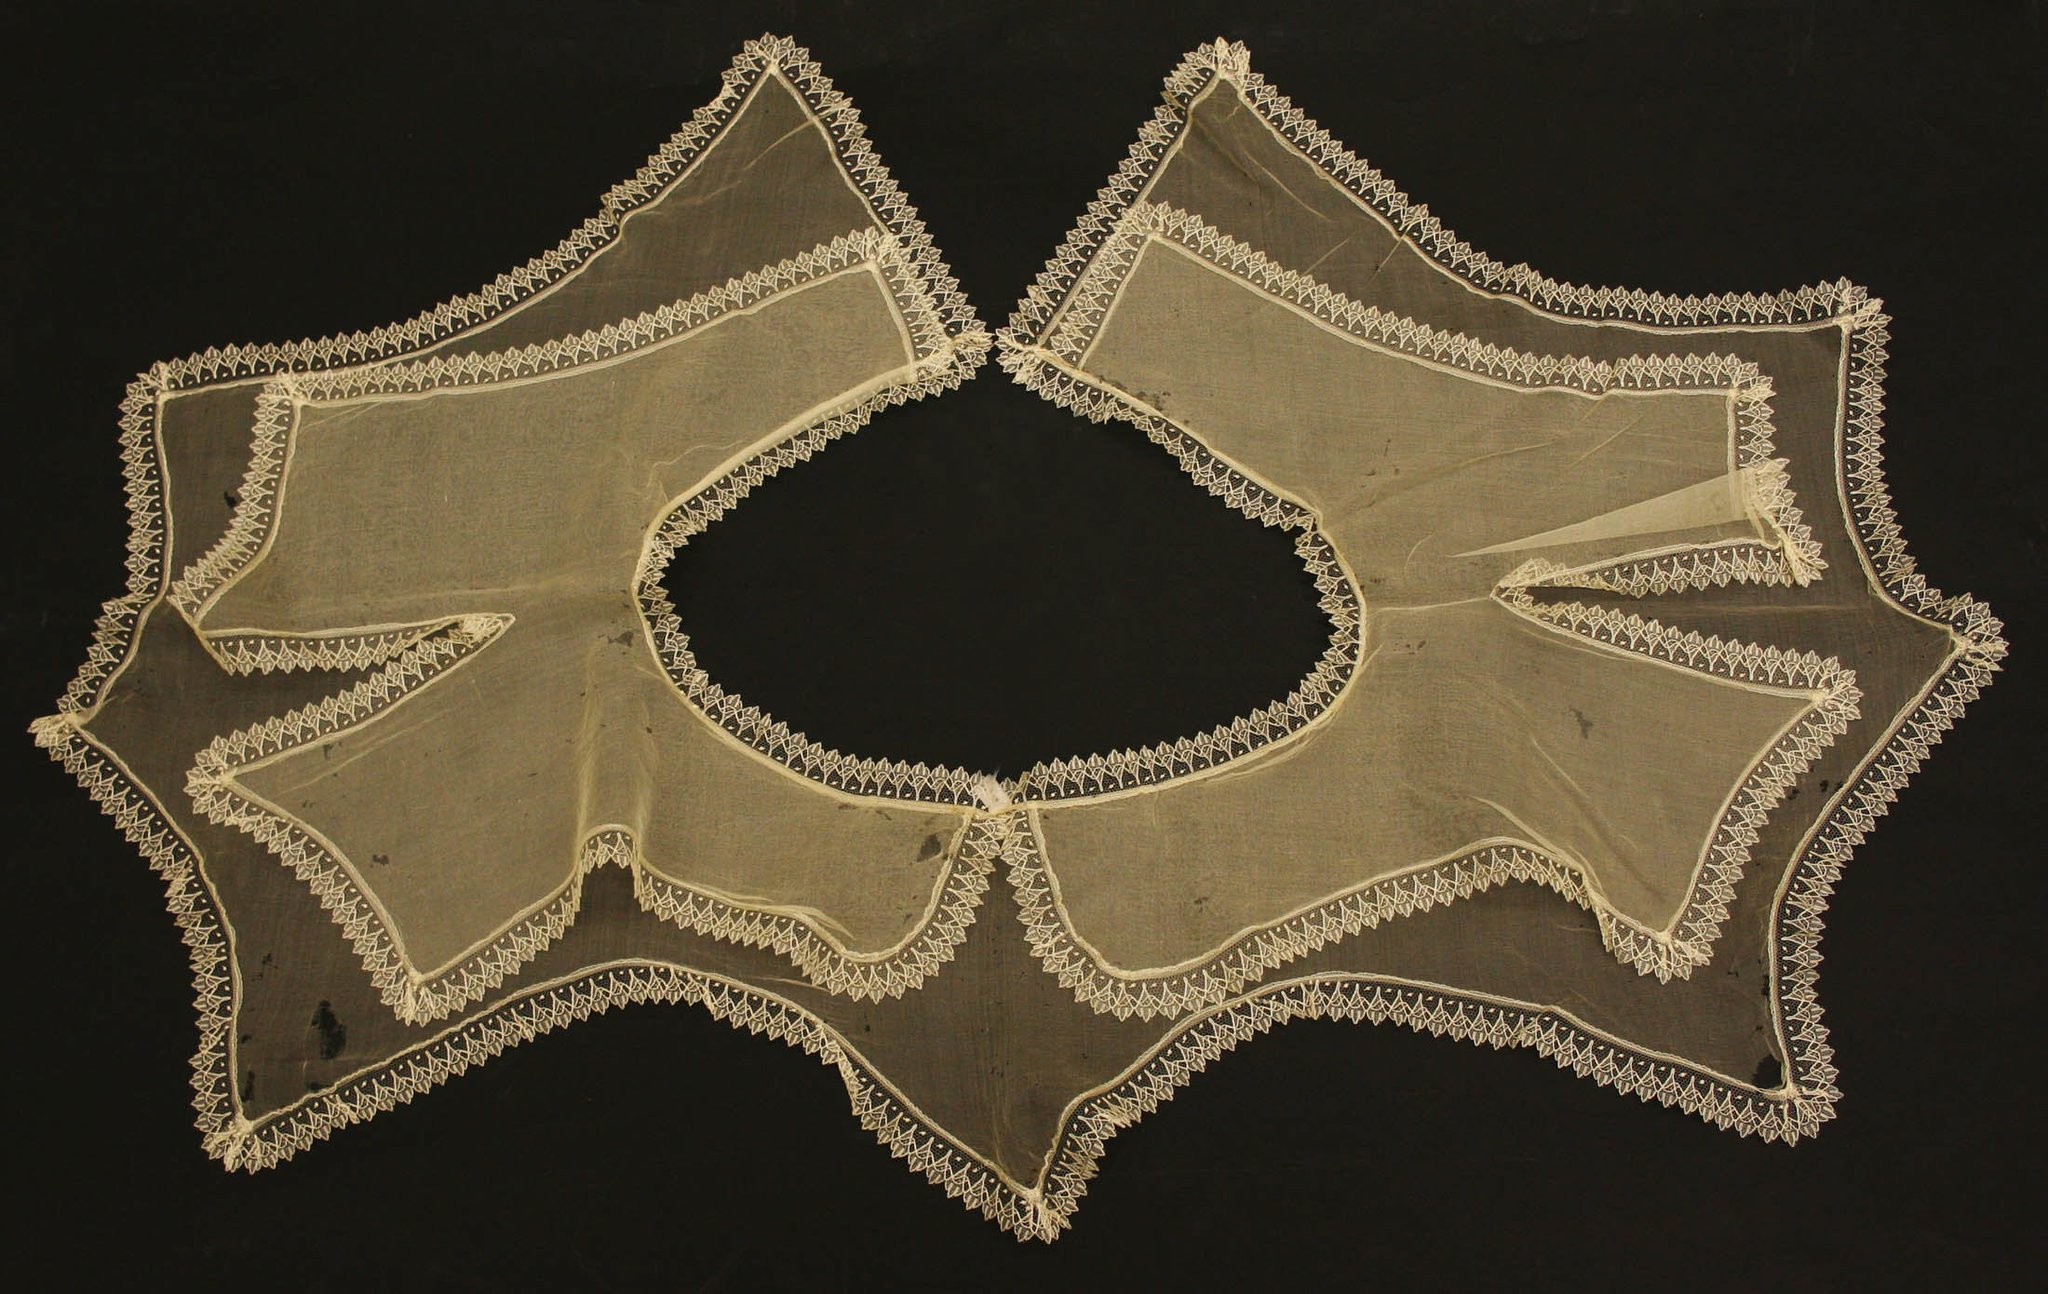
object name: collar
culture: american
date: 1830-1839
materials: cotton